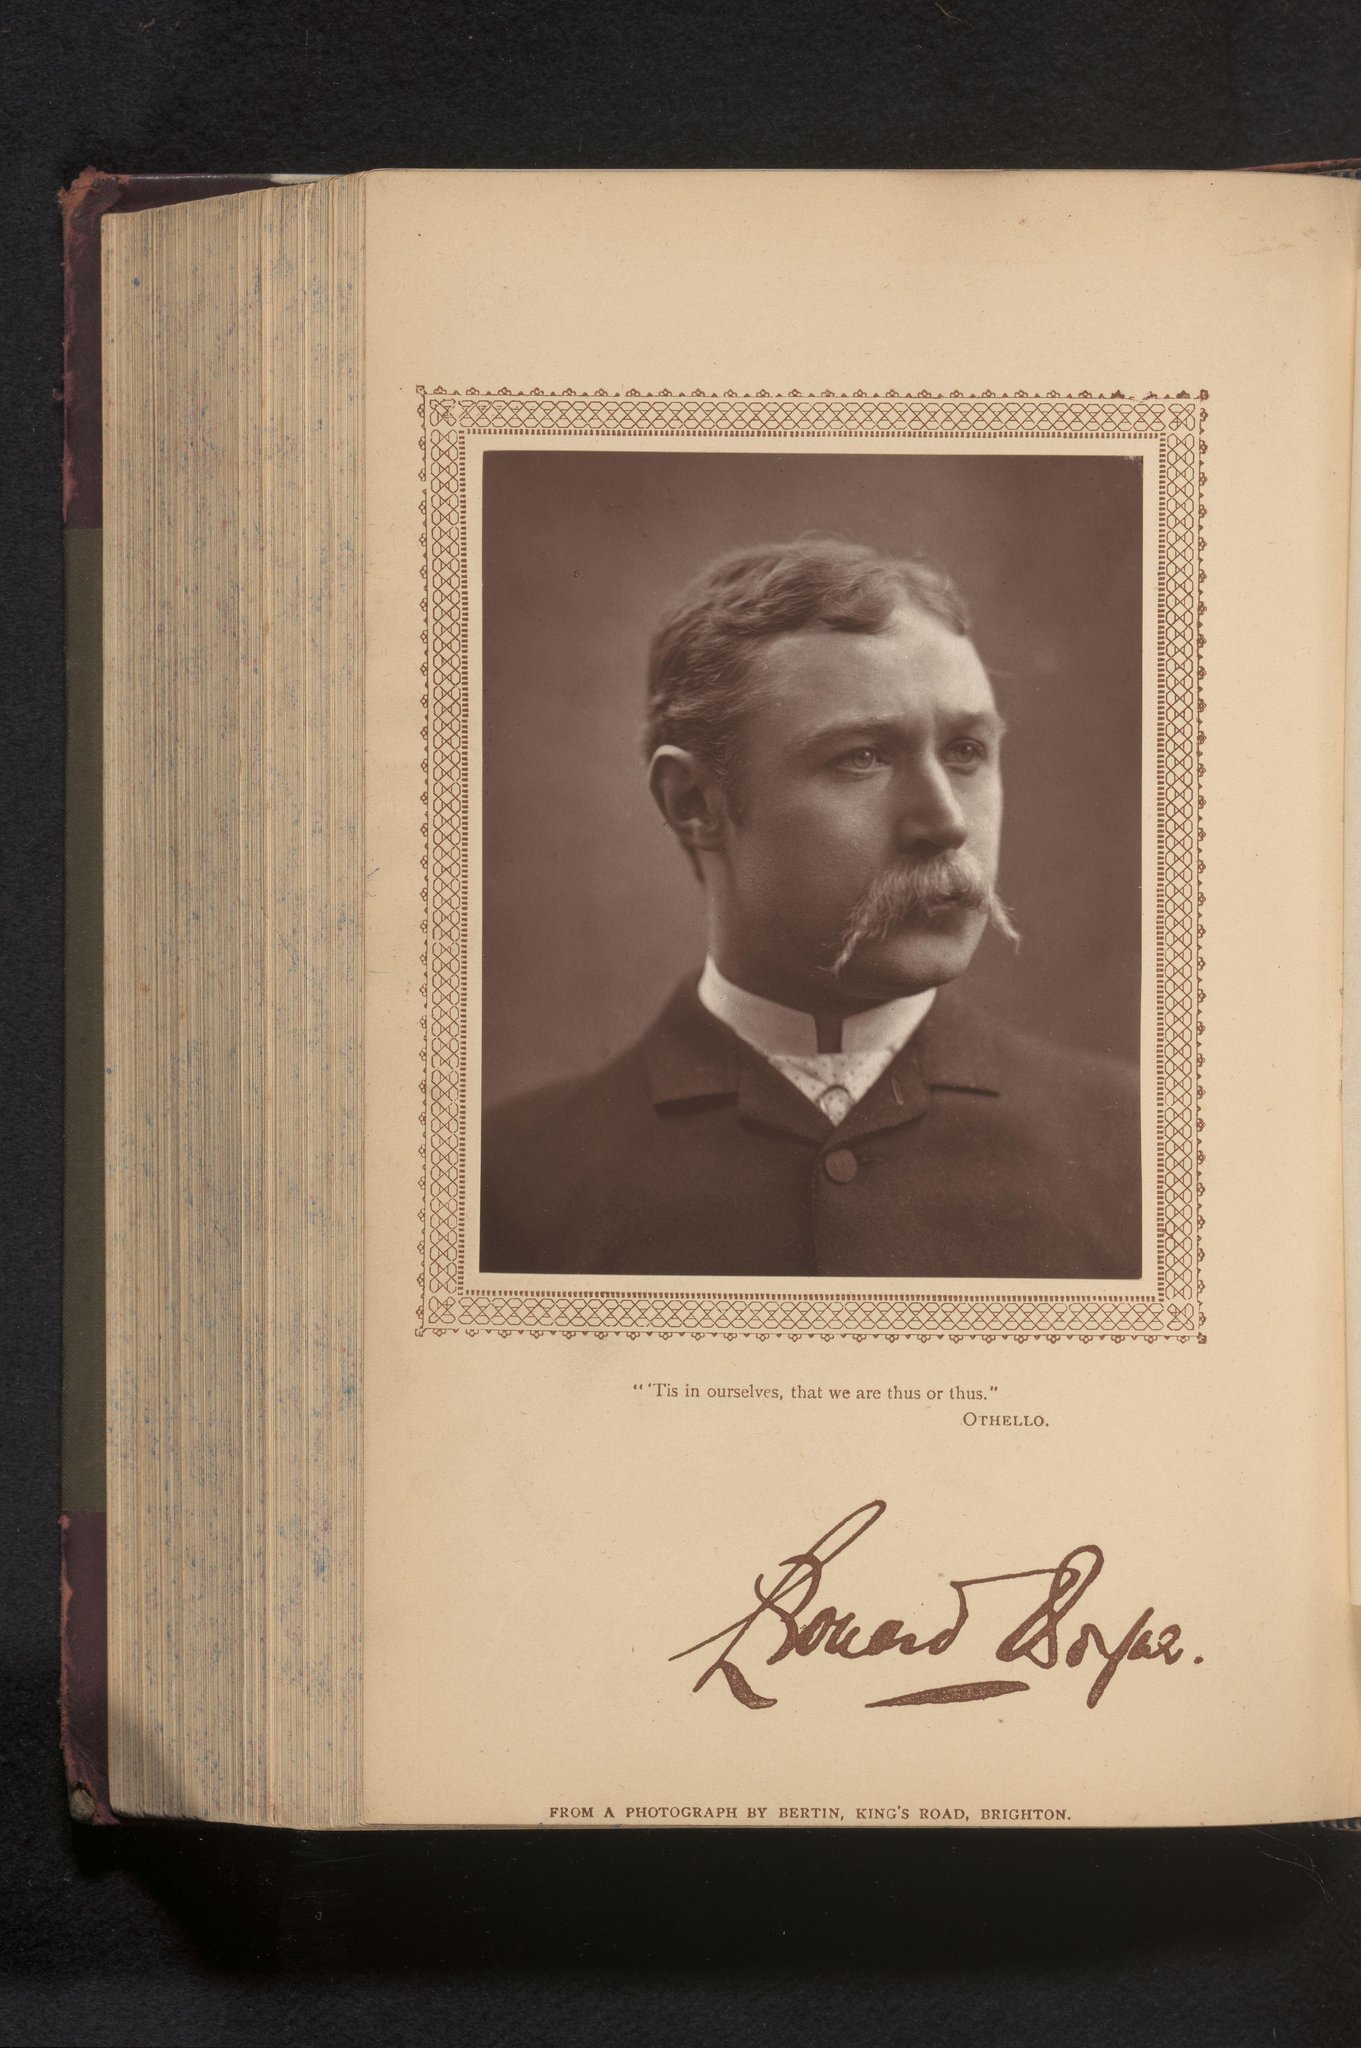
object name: photomechanical print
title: Portret van Leonard Boyne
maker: Anonymous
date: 1879-1884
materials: paper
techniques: woodburytype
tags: adult man, historical persons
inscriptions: signature: ‘Leonard Boyne’, inscription: ‘'Tis in ourselves, that we are thus or thus,'/ Othello’